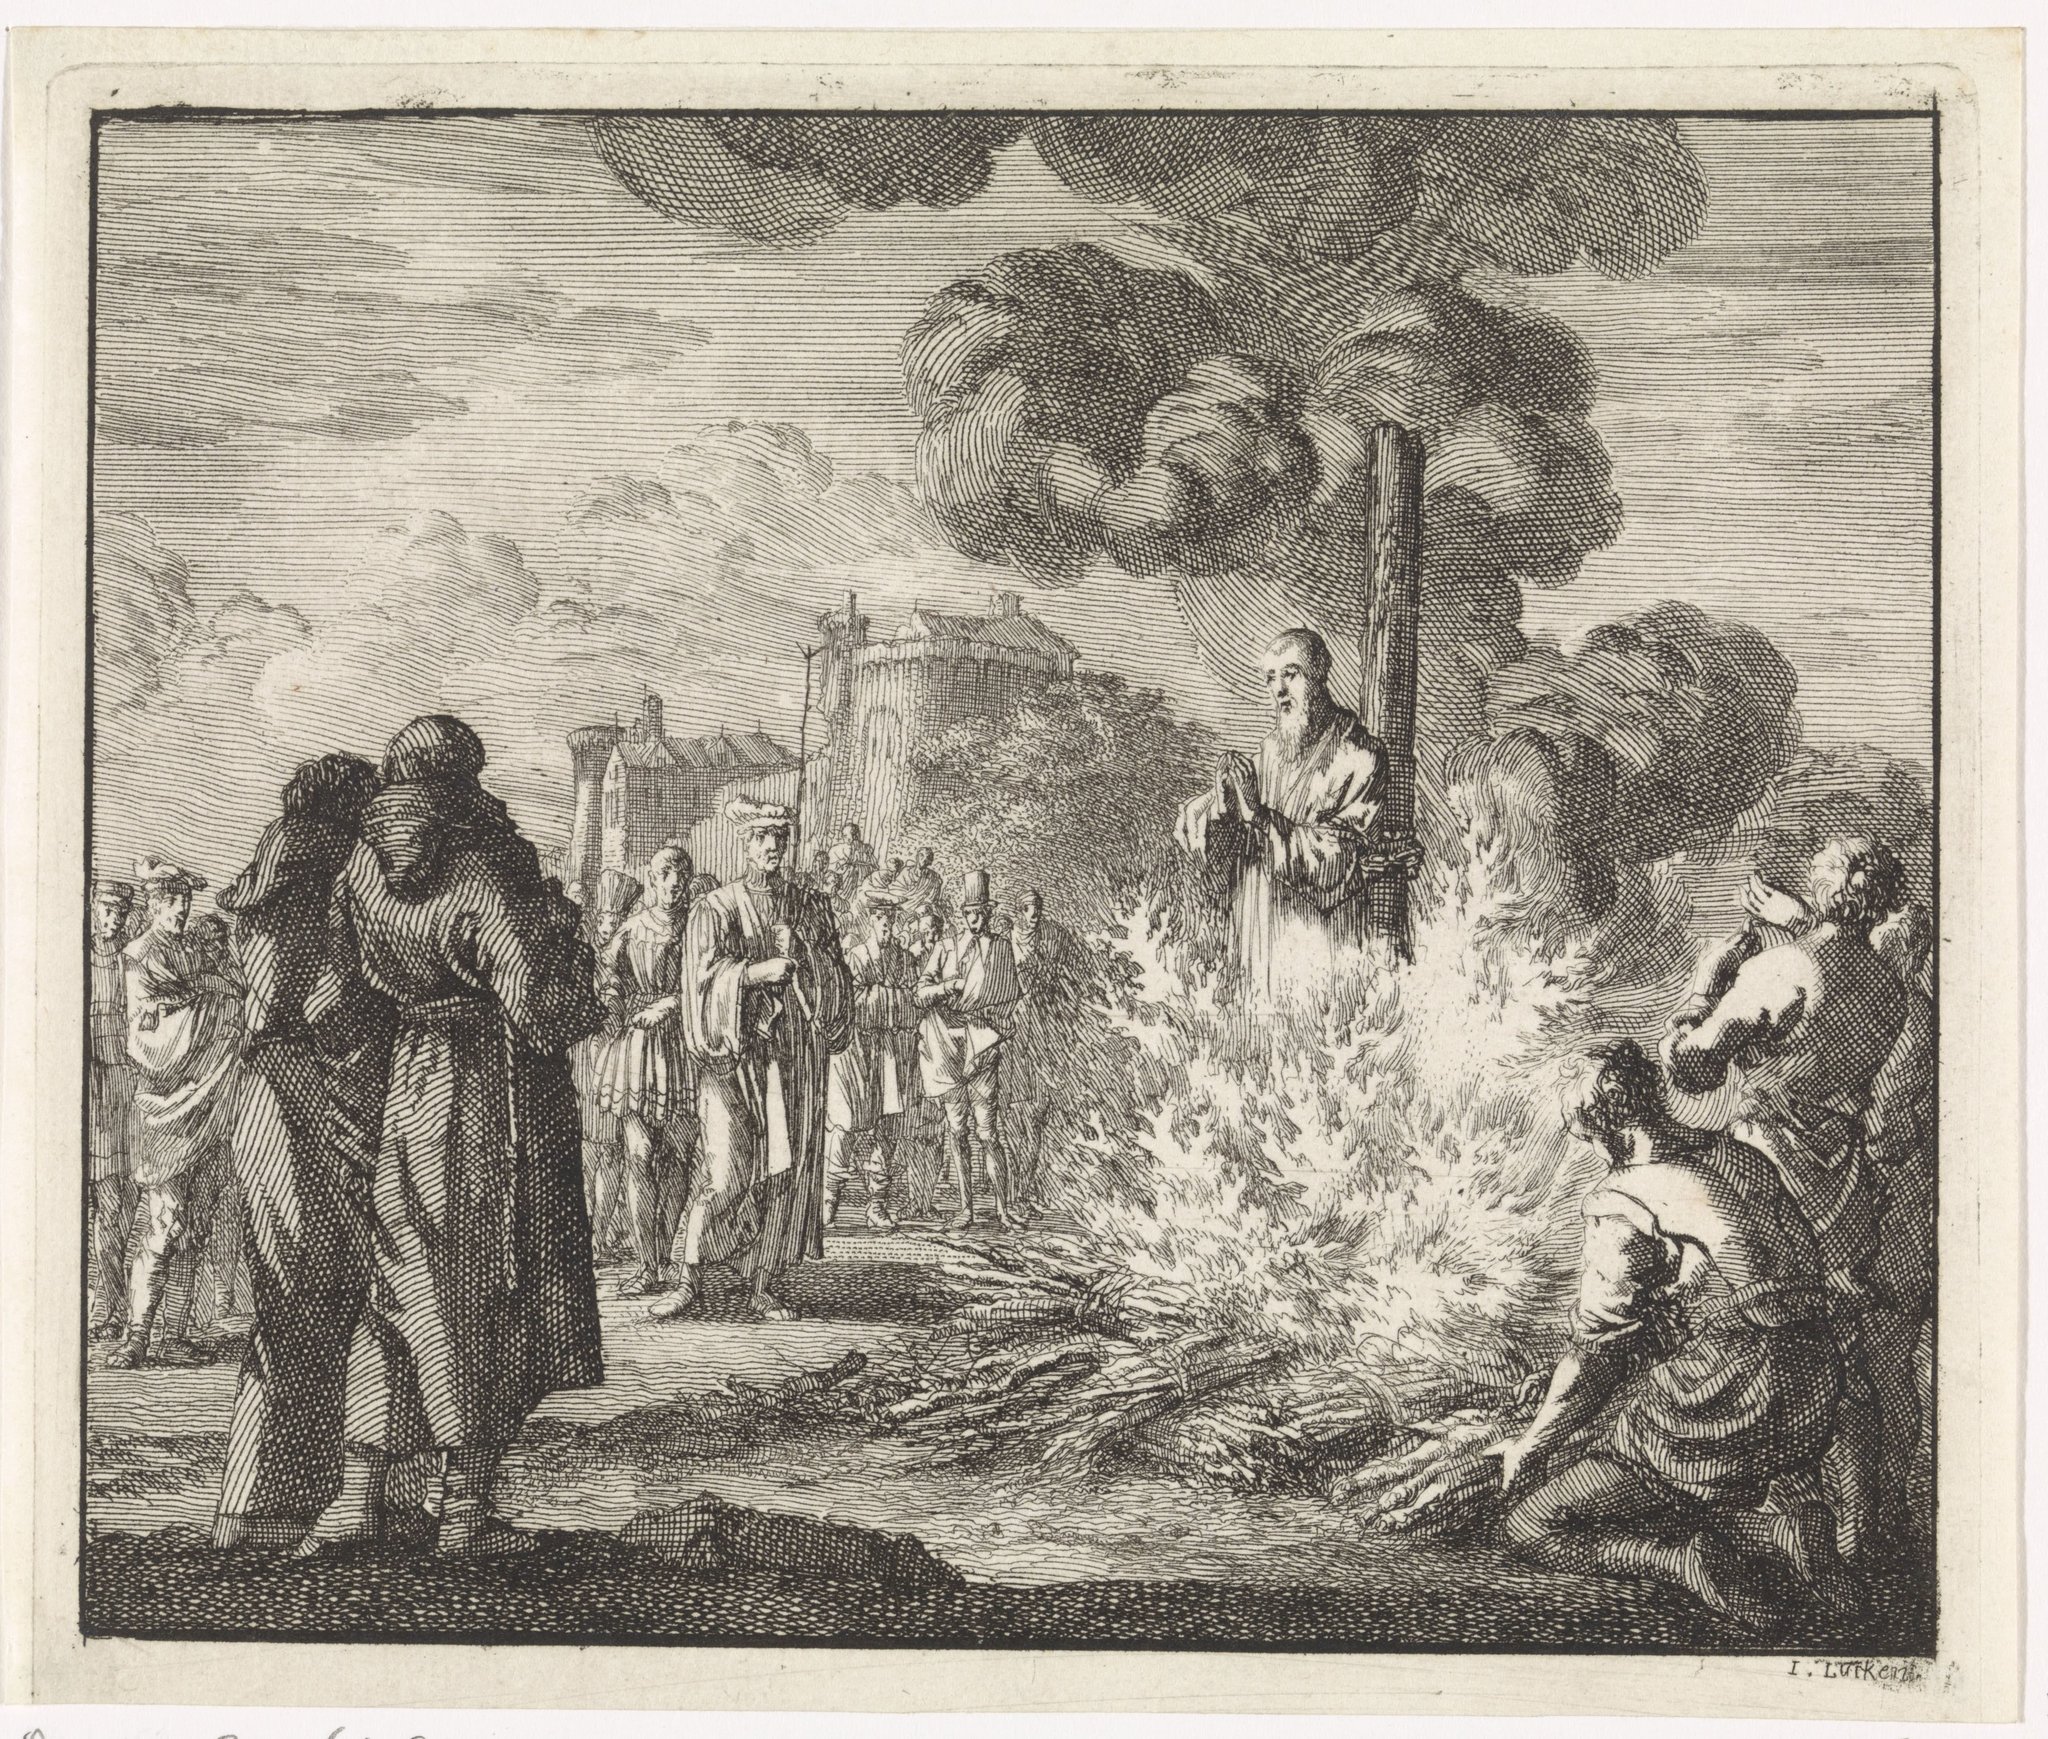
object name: print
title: Arnoldus, bisschop van Brix, wordt op de brandstapel verbrand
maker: jan luyken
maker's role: draughtsman, print maker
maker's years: 1649-1712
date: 1701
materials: paper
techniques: etching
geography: amsterdam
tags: the early christian churches, e.g. armenians, copts, syrians, archbishop, bishop, etc. (roman catholic), monk(s), friar(s), violent death by burning at the stake; pyre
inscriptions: collector's mark: Lugt 2228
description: Proefdruk van een boekillustratie Arnold, Godfried. Waare afbeelding der eerste christenen. Amsterdam: Jacobus van Hardenberg, Barent Visscher en Jacobus van Nieuweveen, 1700, dl. 2.